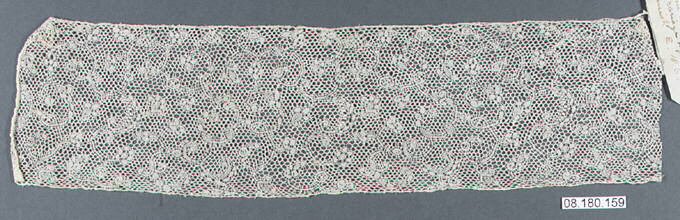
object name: fragment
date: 1701-1733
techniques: lace